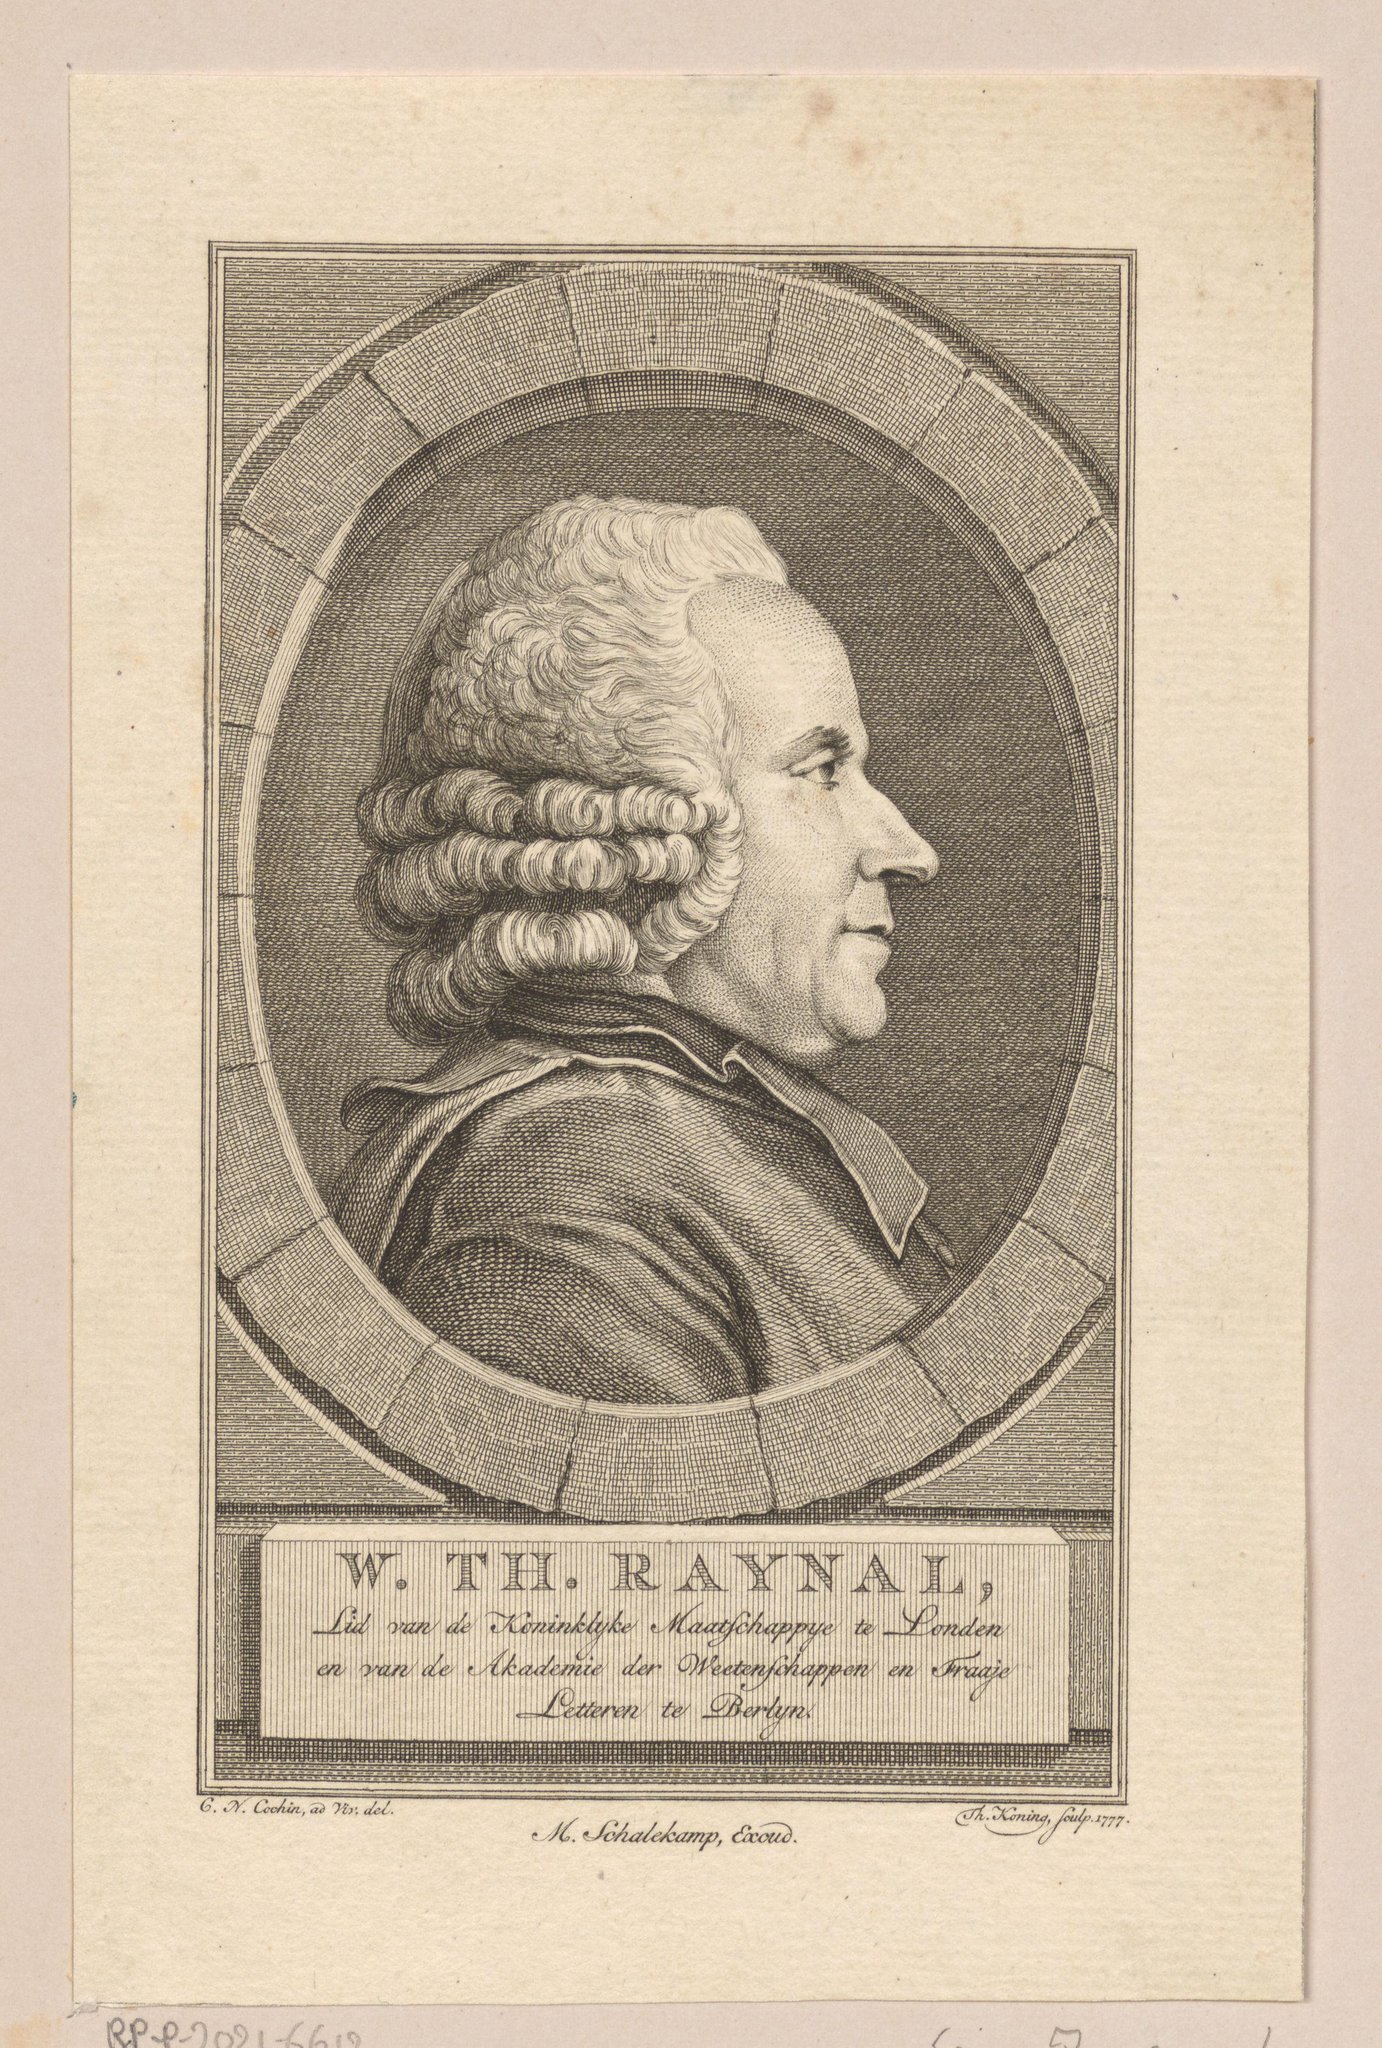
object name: print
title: Portret van Guillaume-Thomas François Raynal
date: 1777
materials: paper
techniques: engraving, etching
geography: amsterdam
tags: historical persons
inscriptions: date